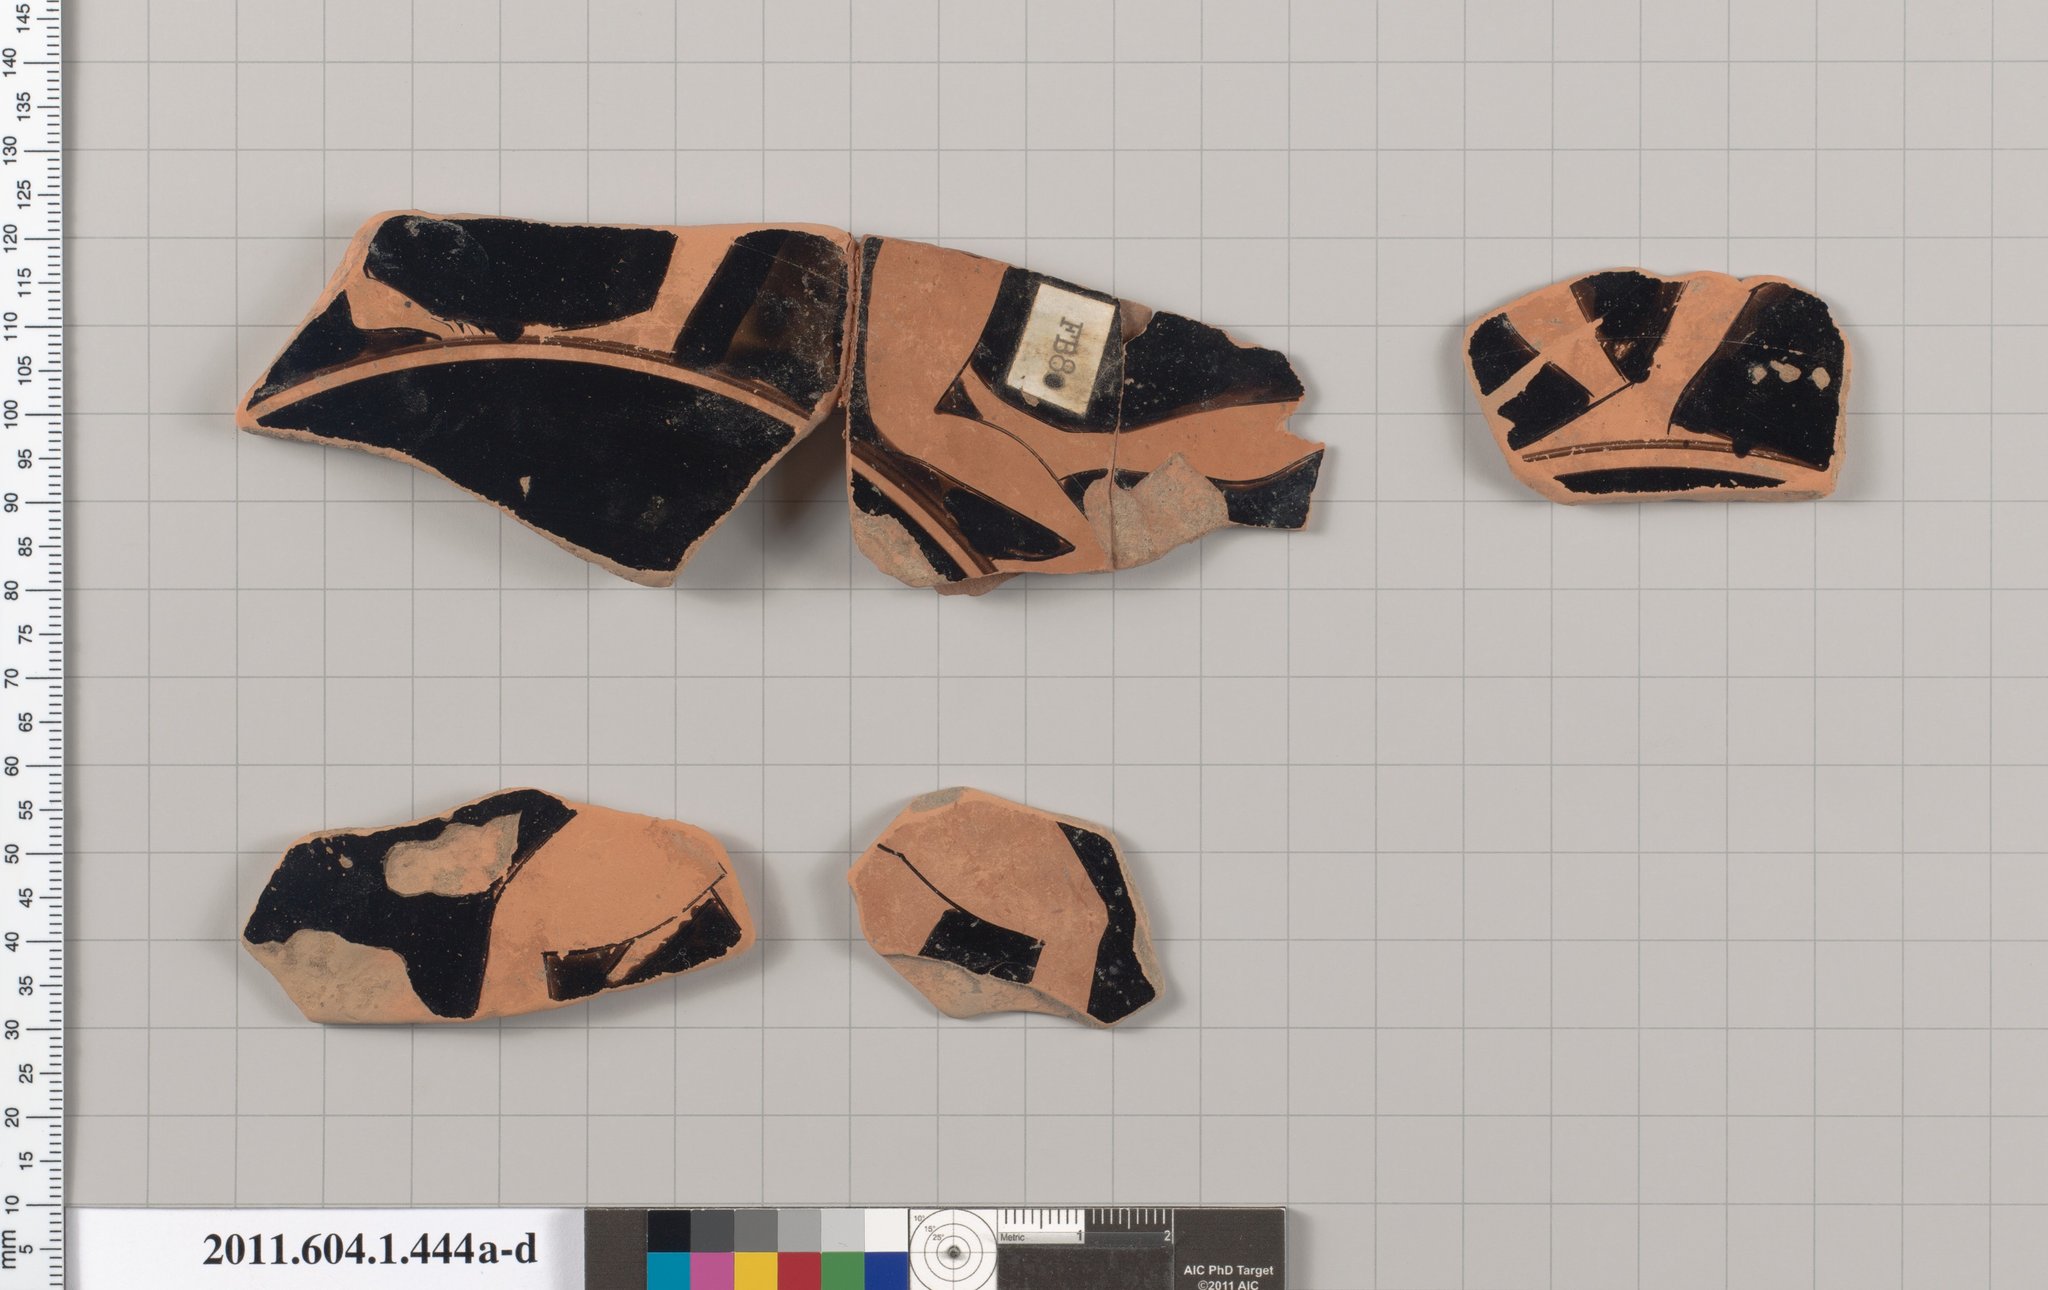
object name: kylix fragment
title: Terracotta fragments of a kylix (drinking cup)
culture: greek, attic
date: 520-500 BCE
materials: terracotta